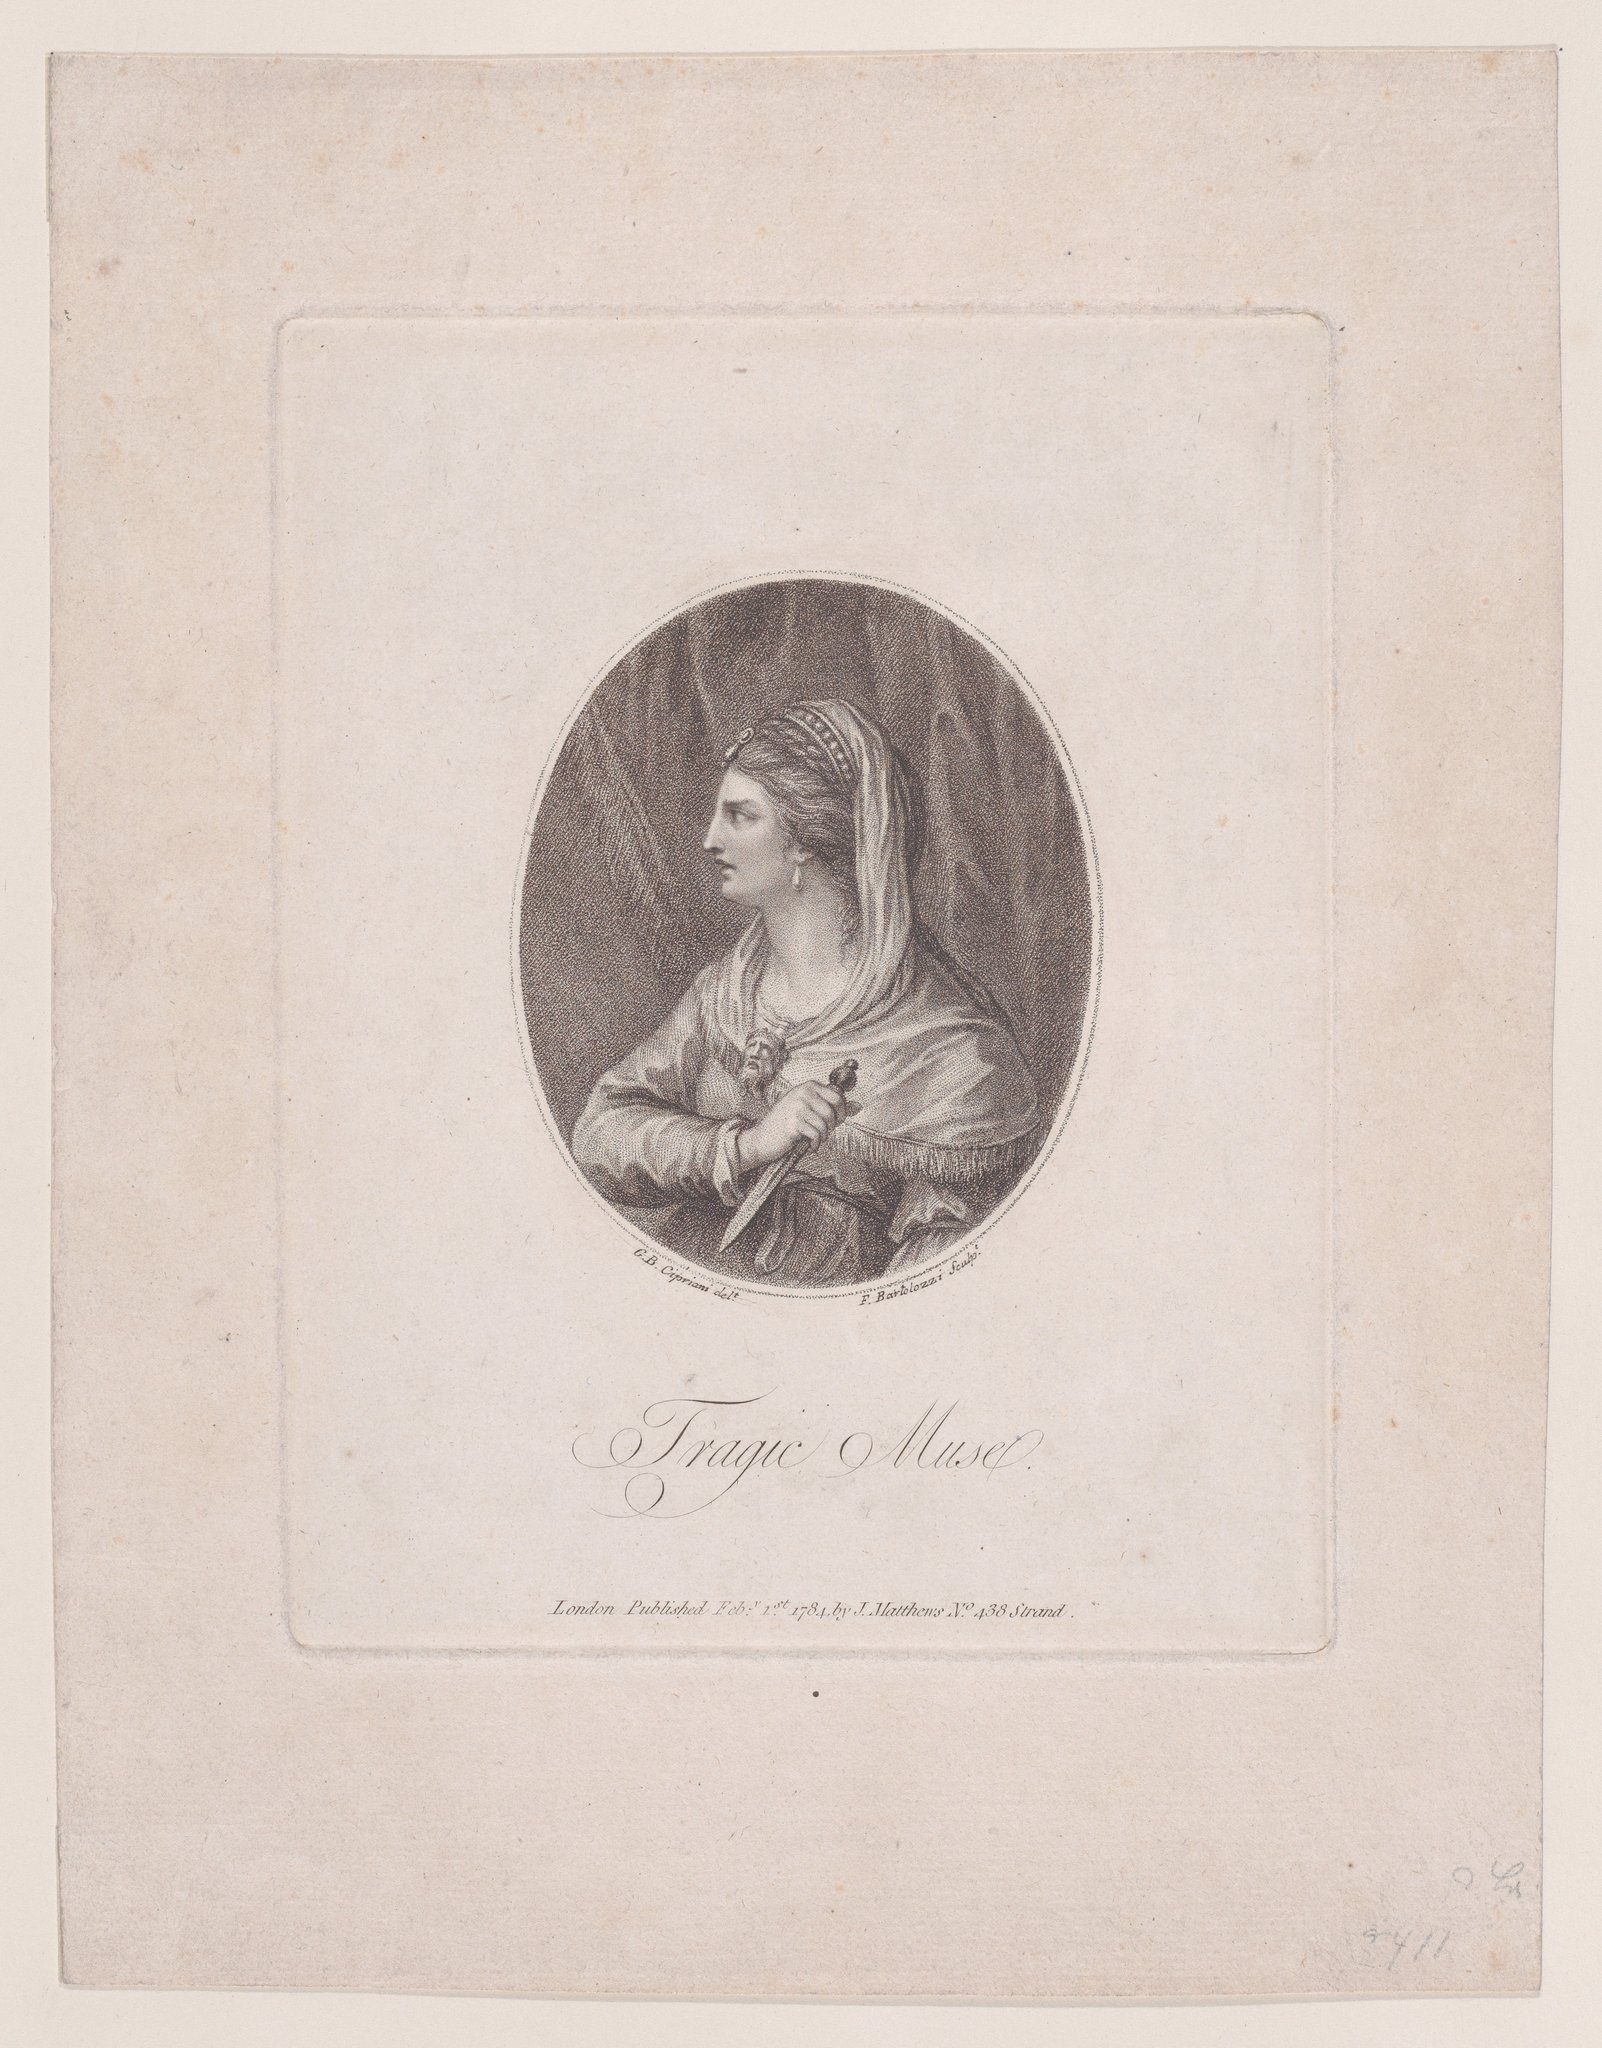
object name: print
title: The Tragic Muse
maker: francesco bartolozzi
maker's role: artist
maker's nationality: italian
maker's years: 1728-1815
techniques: etching, printing, engraving